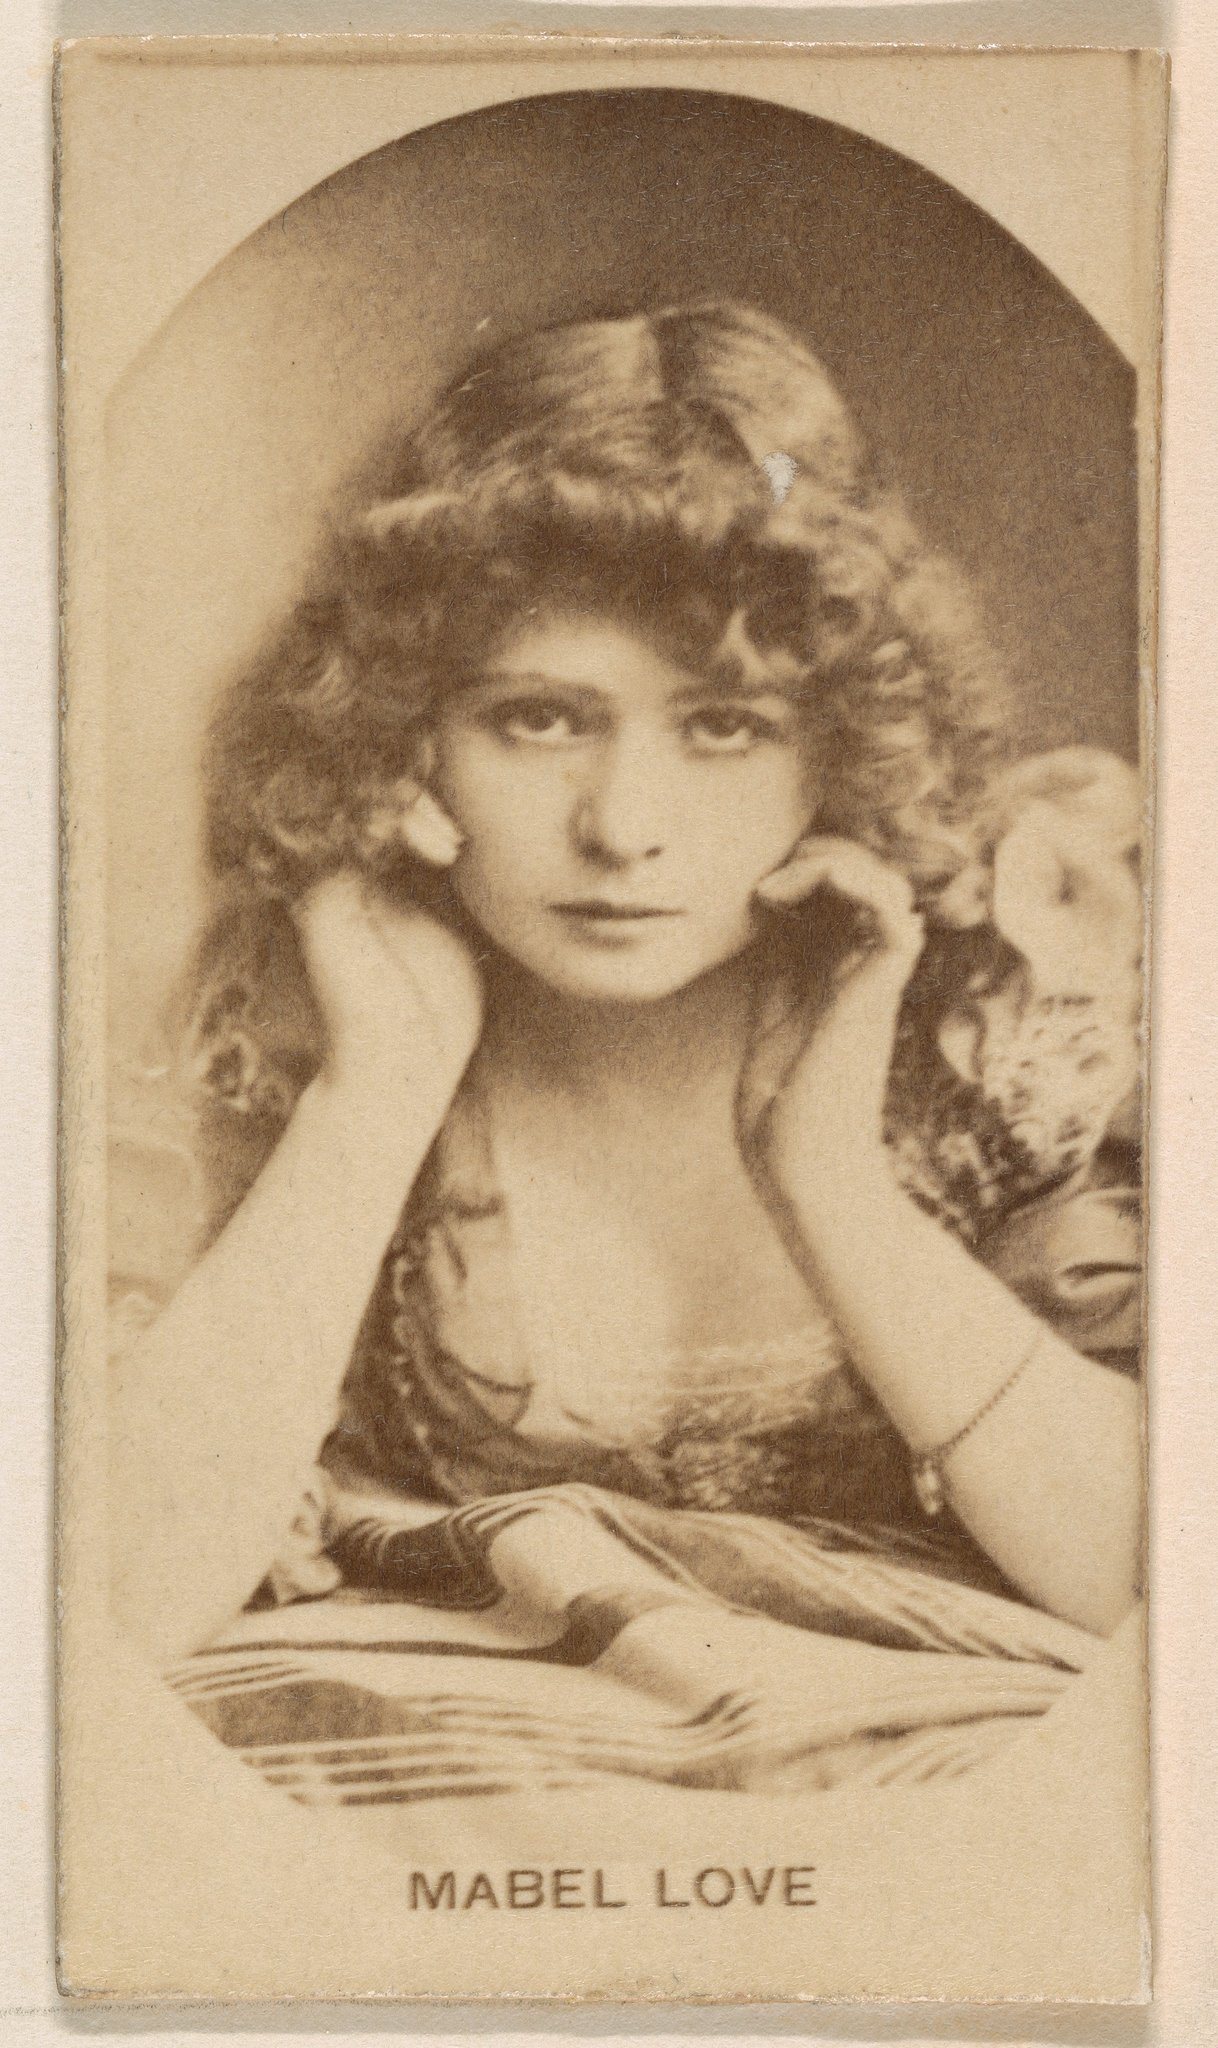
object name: photograph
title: Miss Mabel Love, from the Actresses series (N245) issued by Kinney Brothers to promote Sweet Caporal Cigarettes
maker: kinney brothers tobacco company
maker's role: publisher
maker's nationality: american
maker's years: 1869-2011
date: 1890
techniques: albumen silver print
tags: portraits,women,actresses